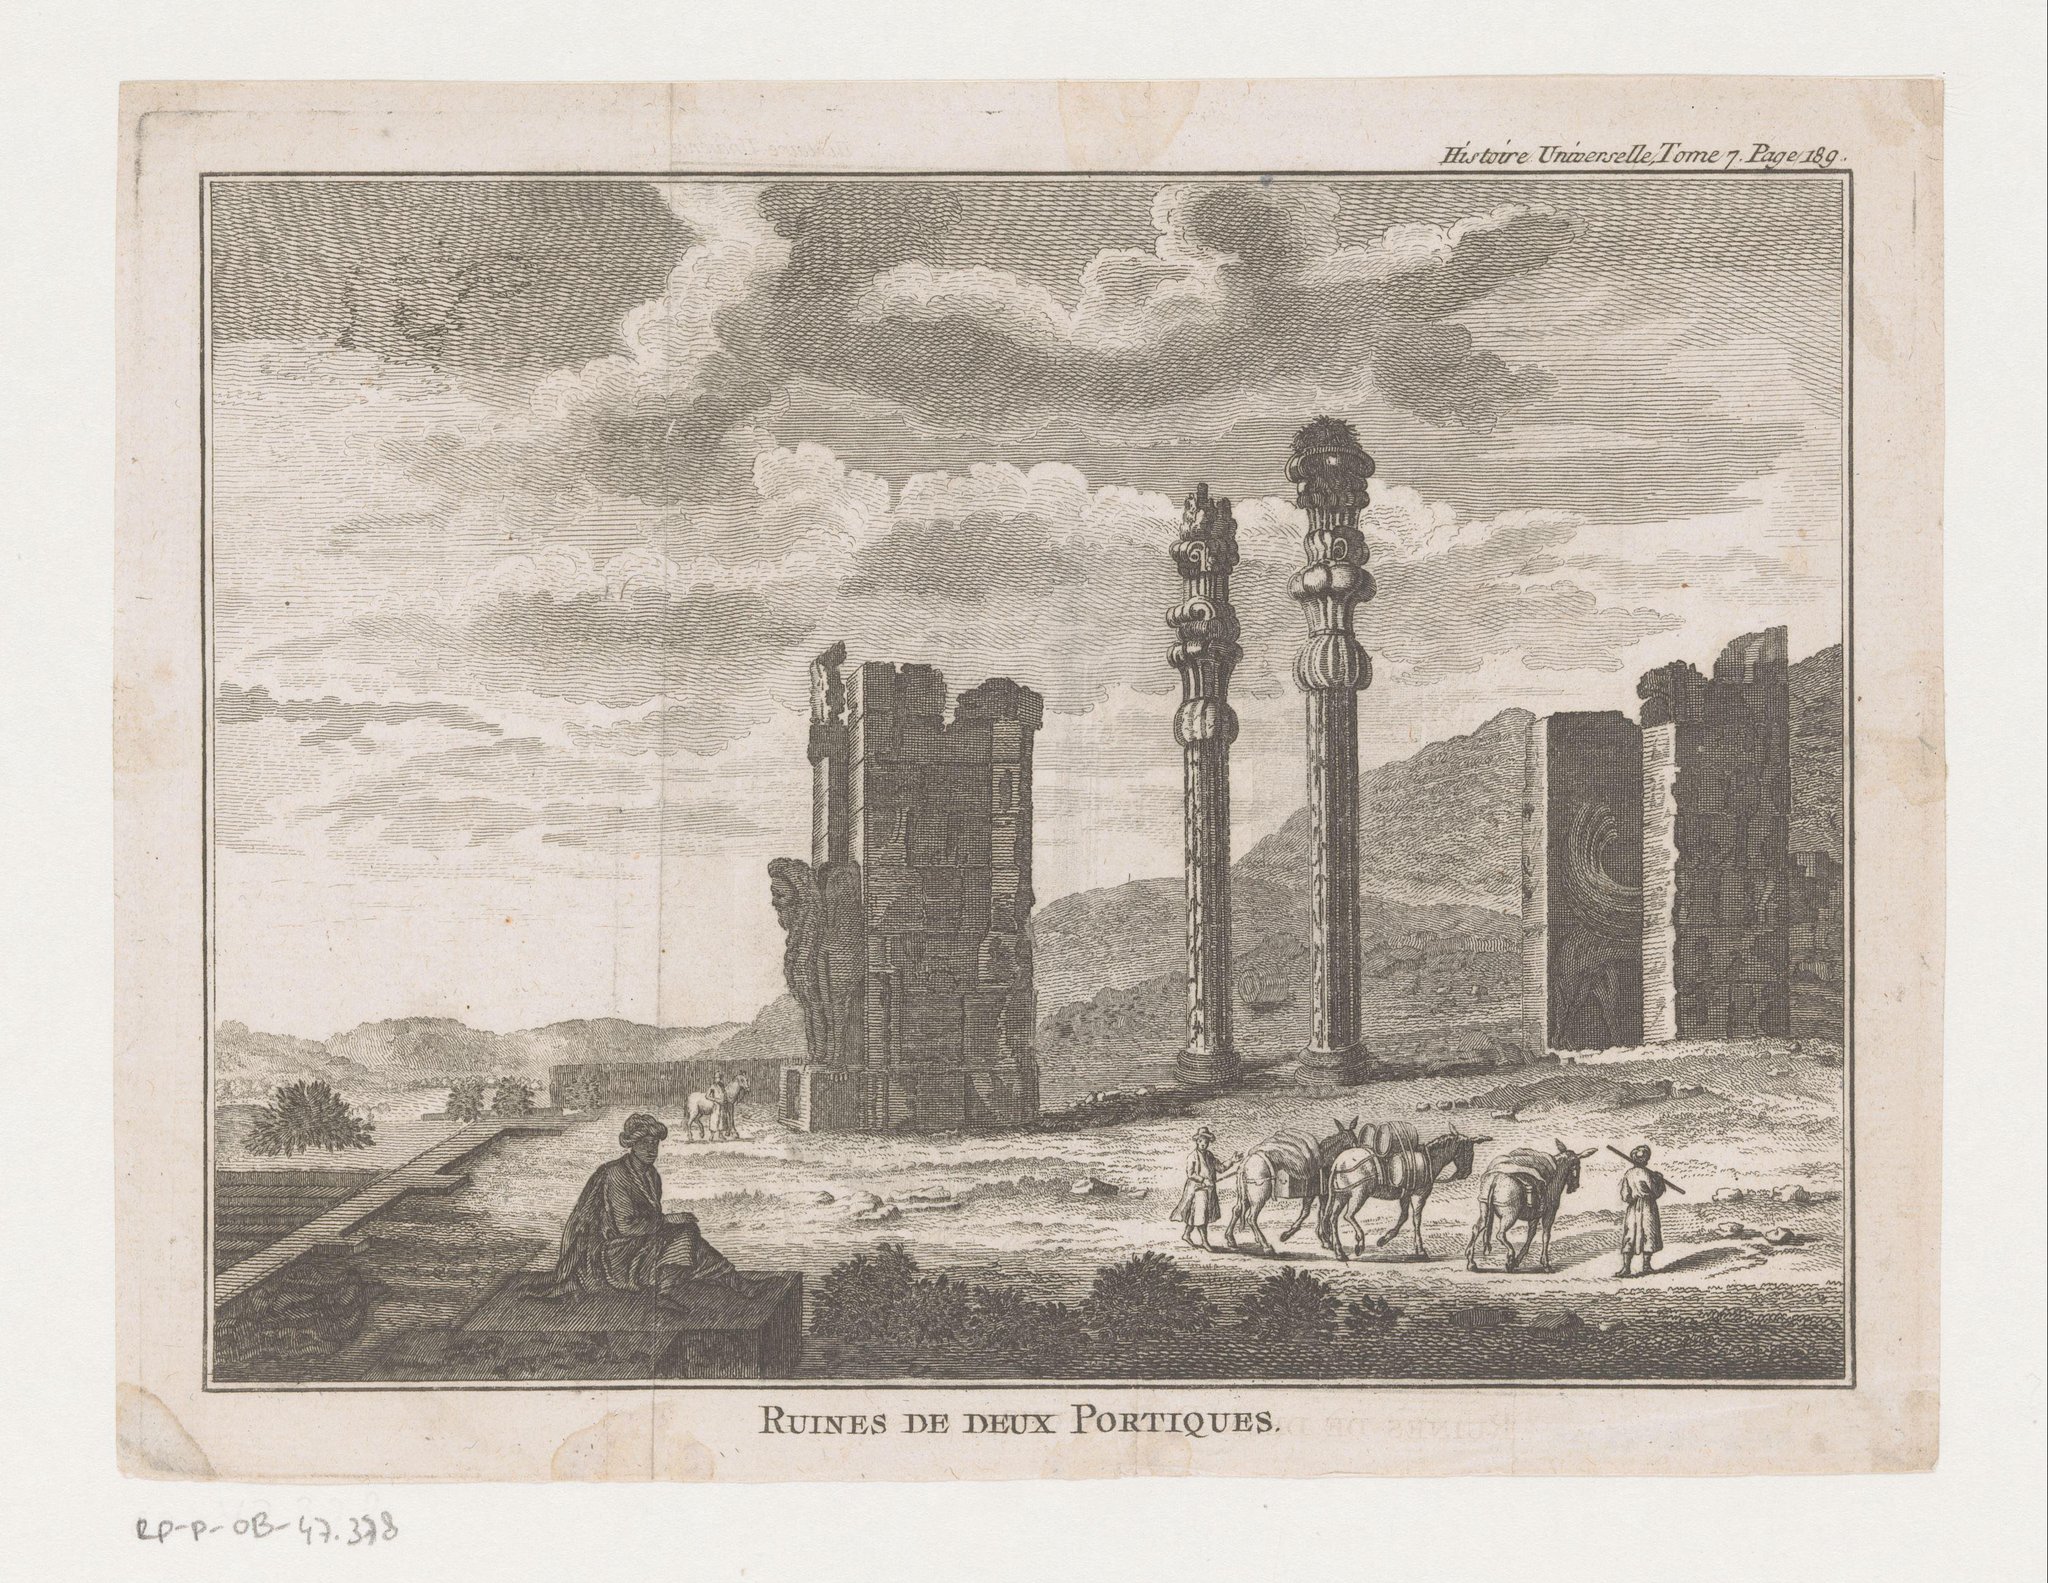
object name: print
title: Ruïnes van twee portalen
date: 1752-1803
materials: paper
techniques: etching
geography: paris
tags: landscape with ruins, persia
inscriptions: collector's mark: Lugt 2228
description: Prent uit: Histoire universelle (...) Tome septieme, contenant la suite de l'histoire des Babyloniens, celle des Medes, & celle des Perses jusqu'a la mort de Darius Codomon, d'apres les auteurs grecs & latins. Parijs: Nicolas-Léger Moutard, s.a. dl. 7, p. 189.